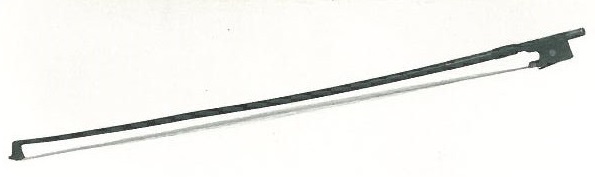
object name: violin bow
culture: french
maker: dominique peccatte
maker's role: maker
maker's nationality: french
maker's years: 1810-1874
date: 1845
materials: wood, hair, ivory, mother of pearl, silver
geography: france